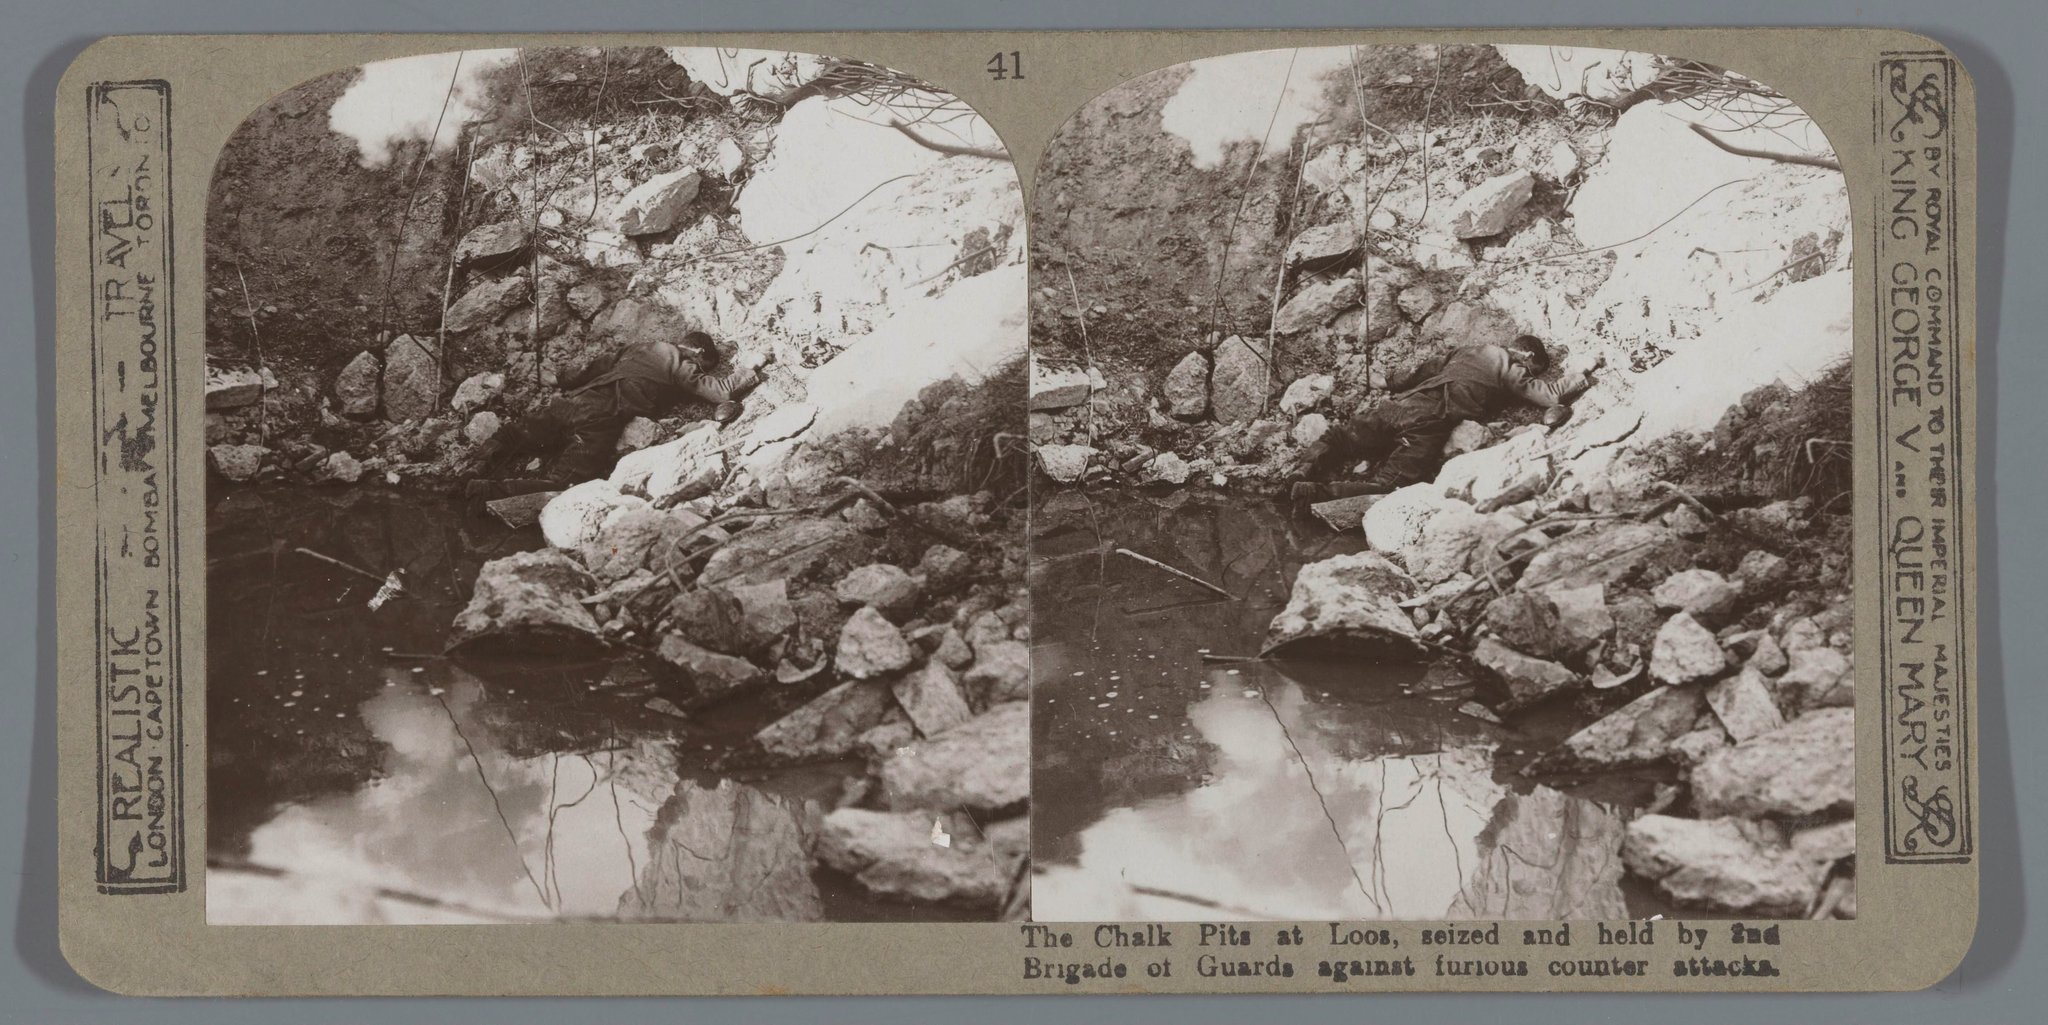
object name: stereograph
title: The Chalk Pits at Loos, seized and held by 2nd Brigade of Guards against furious counter attacks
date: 1914-1918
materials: cardboard, photographic support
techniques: gelatin silver print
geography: pas-de-calais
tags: private soldier, the corpse, pit, hole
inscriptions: inscription: ‘By Royal command to their Imperial majesties King George V and Queen Mary’, number: ‘41’